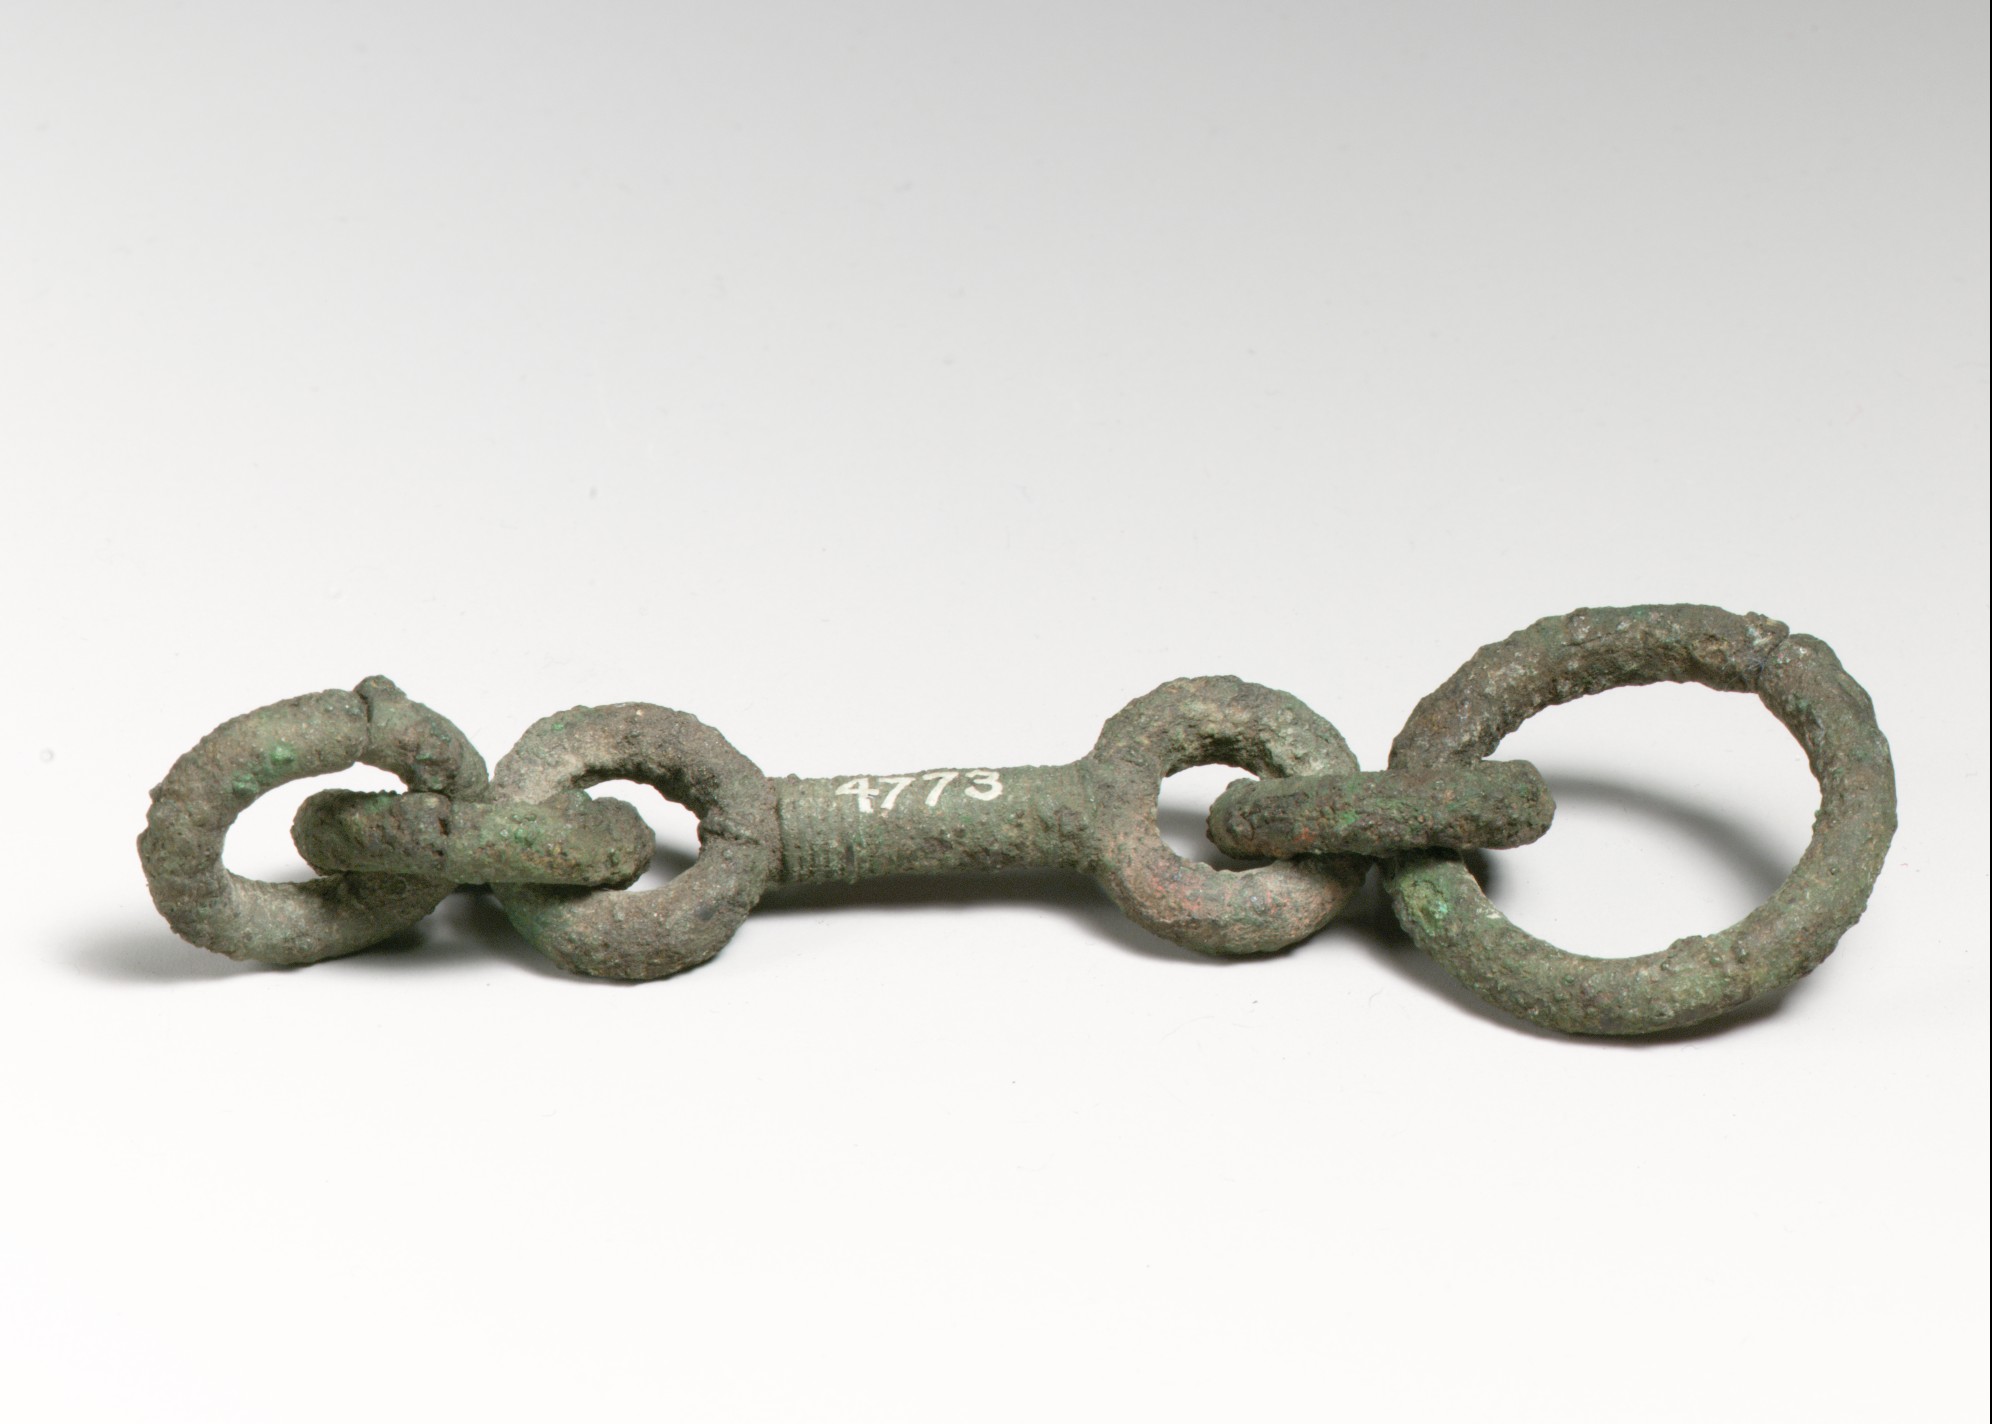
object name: horse bit, part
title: Part of a bronze bit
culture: cypriot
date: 600-480 BCE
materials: bronze